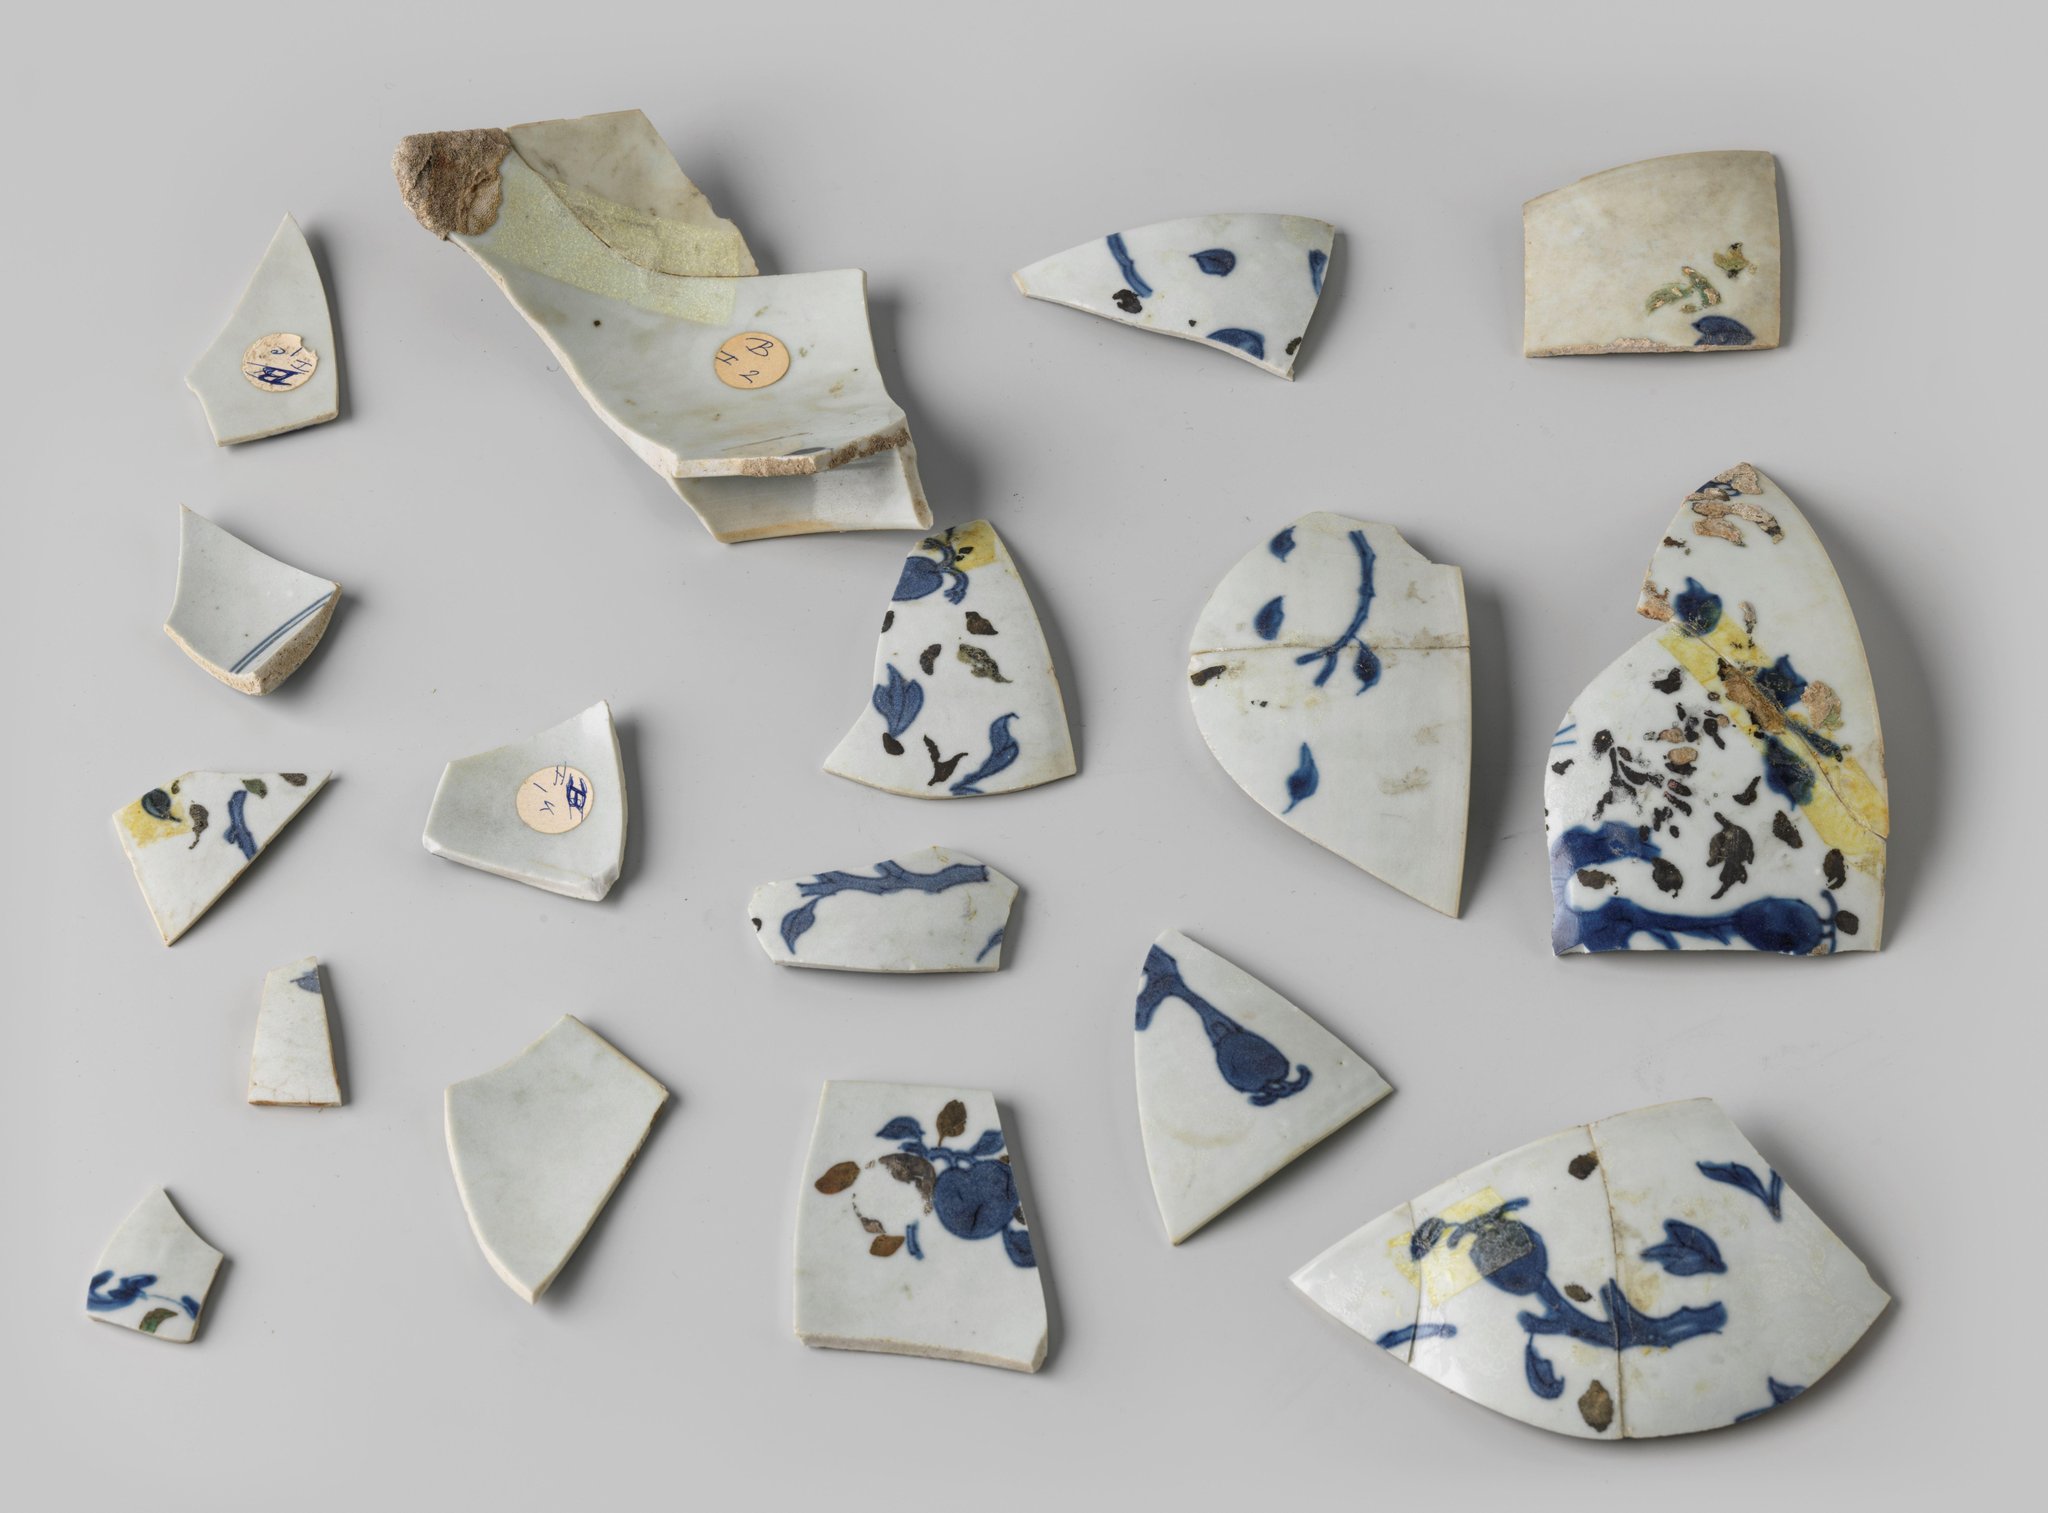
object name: dish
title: Zestien porseleinen scherven van een borden of schalen, gevonden bij V.O.C.-schip Witte Leeuw, mogelijk afkomstig van Zeelelie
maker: Anonymous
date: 1775-1800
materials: porcelain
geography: china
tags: verenigde oostindische compagnie, sint-helena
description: Zestien porseleinen scherven van een borden of schalen, waarvan vier uit twee aan elkaar gelijmde fragmenten, met (resten van) Aziatische beschildering, gevonden bij V.O.C.-schip de 'Witte Leeuw'. Dit object is 18e-eeuws en kan dus niet van de vracht van de Witte Leeuw zijn. Onduidelijk is of het object van de site komt of dat het later is vermengd, mogelijk met materiaal van de Zeelelie.